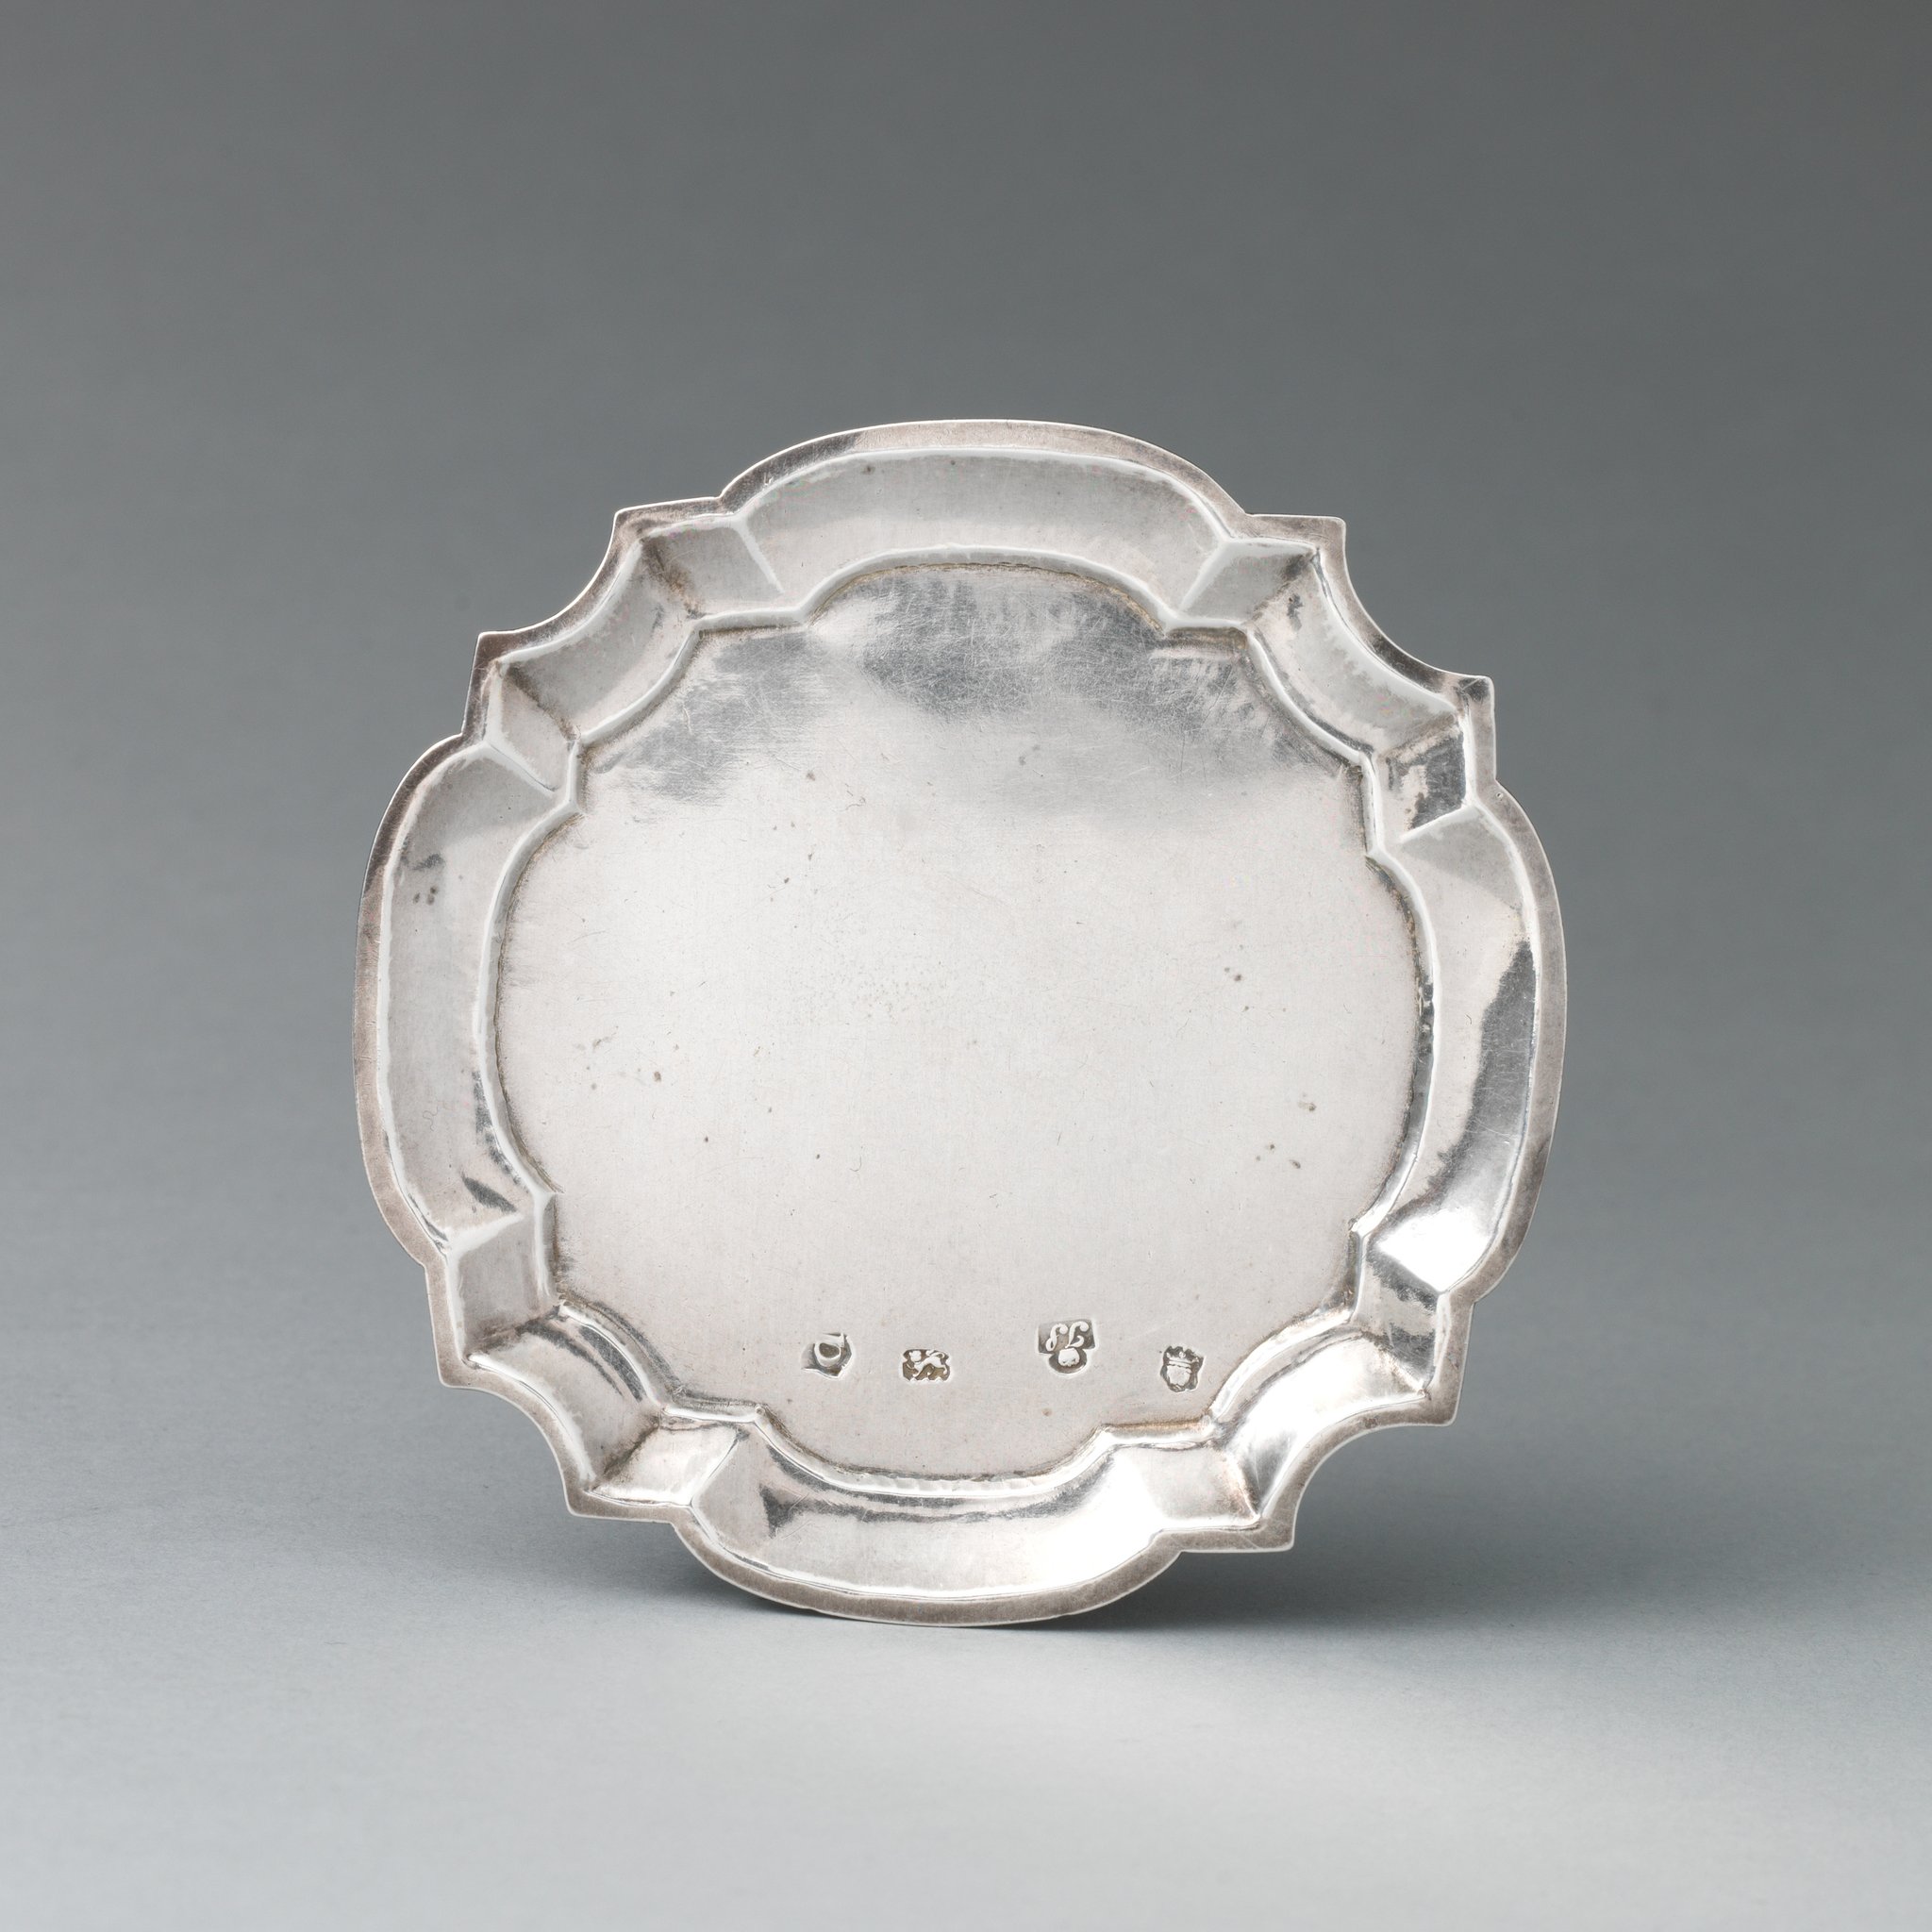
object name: waiter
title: Miniature waiter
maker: john le sage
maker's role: maker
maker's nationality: british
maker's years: 1718-1743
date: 1739-1740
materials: silver